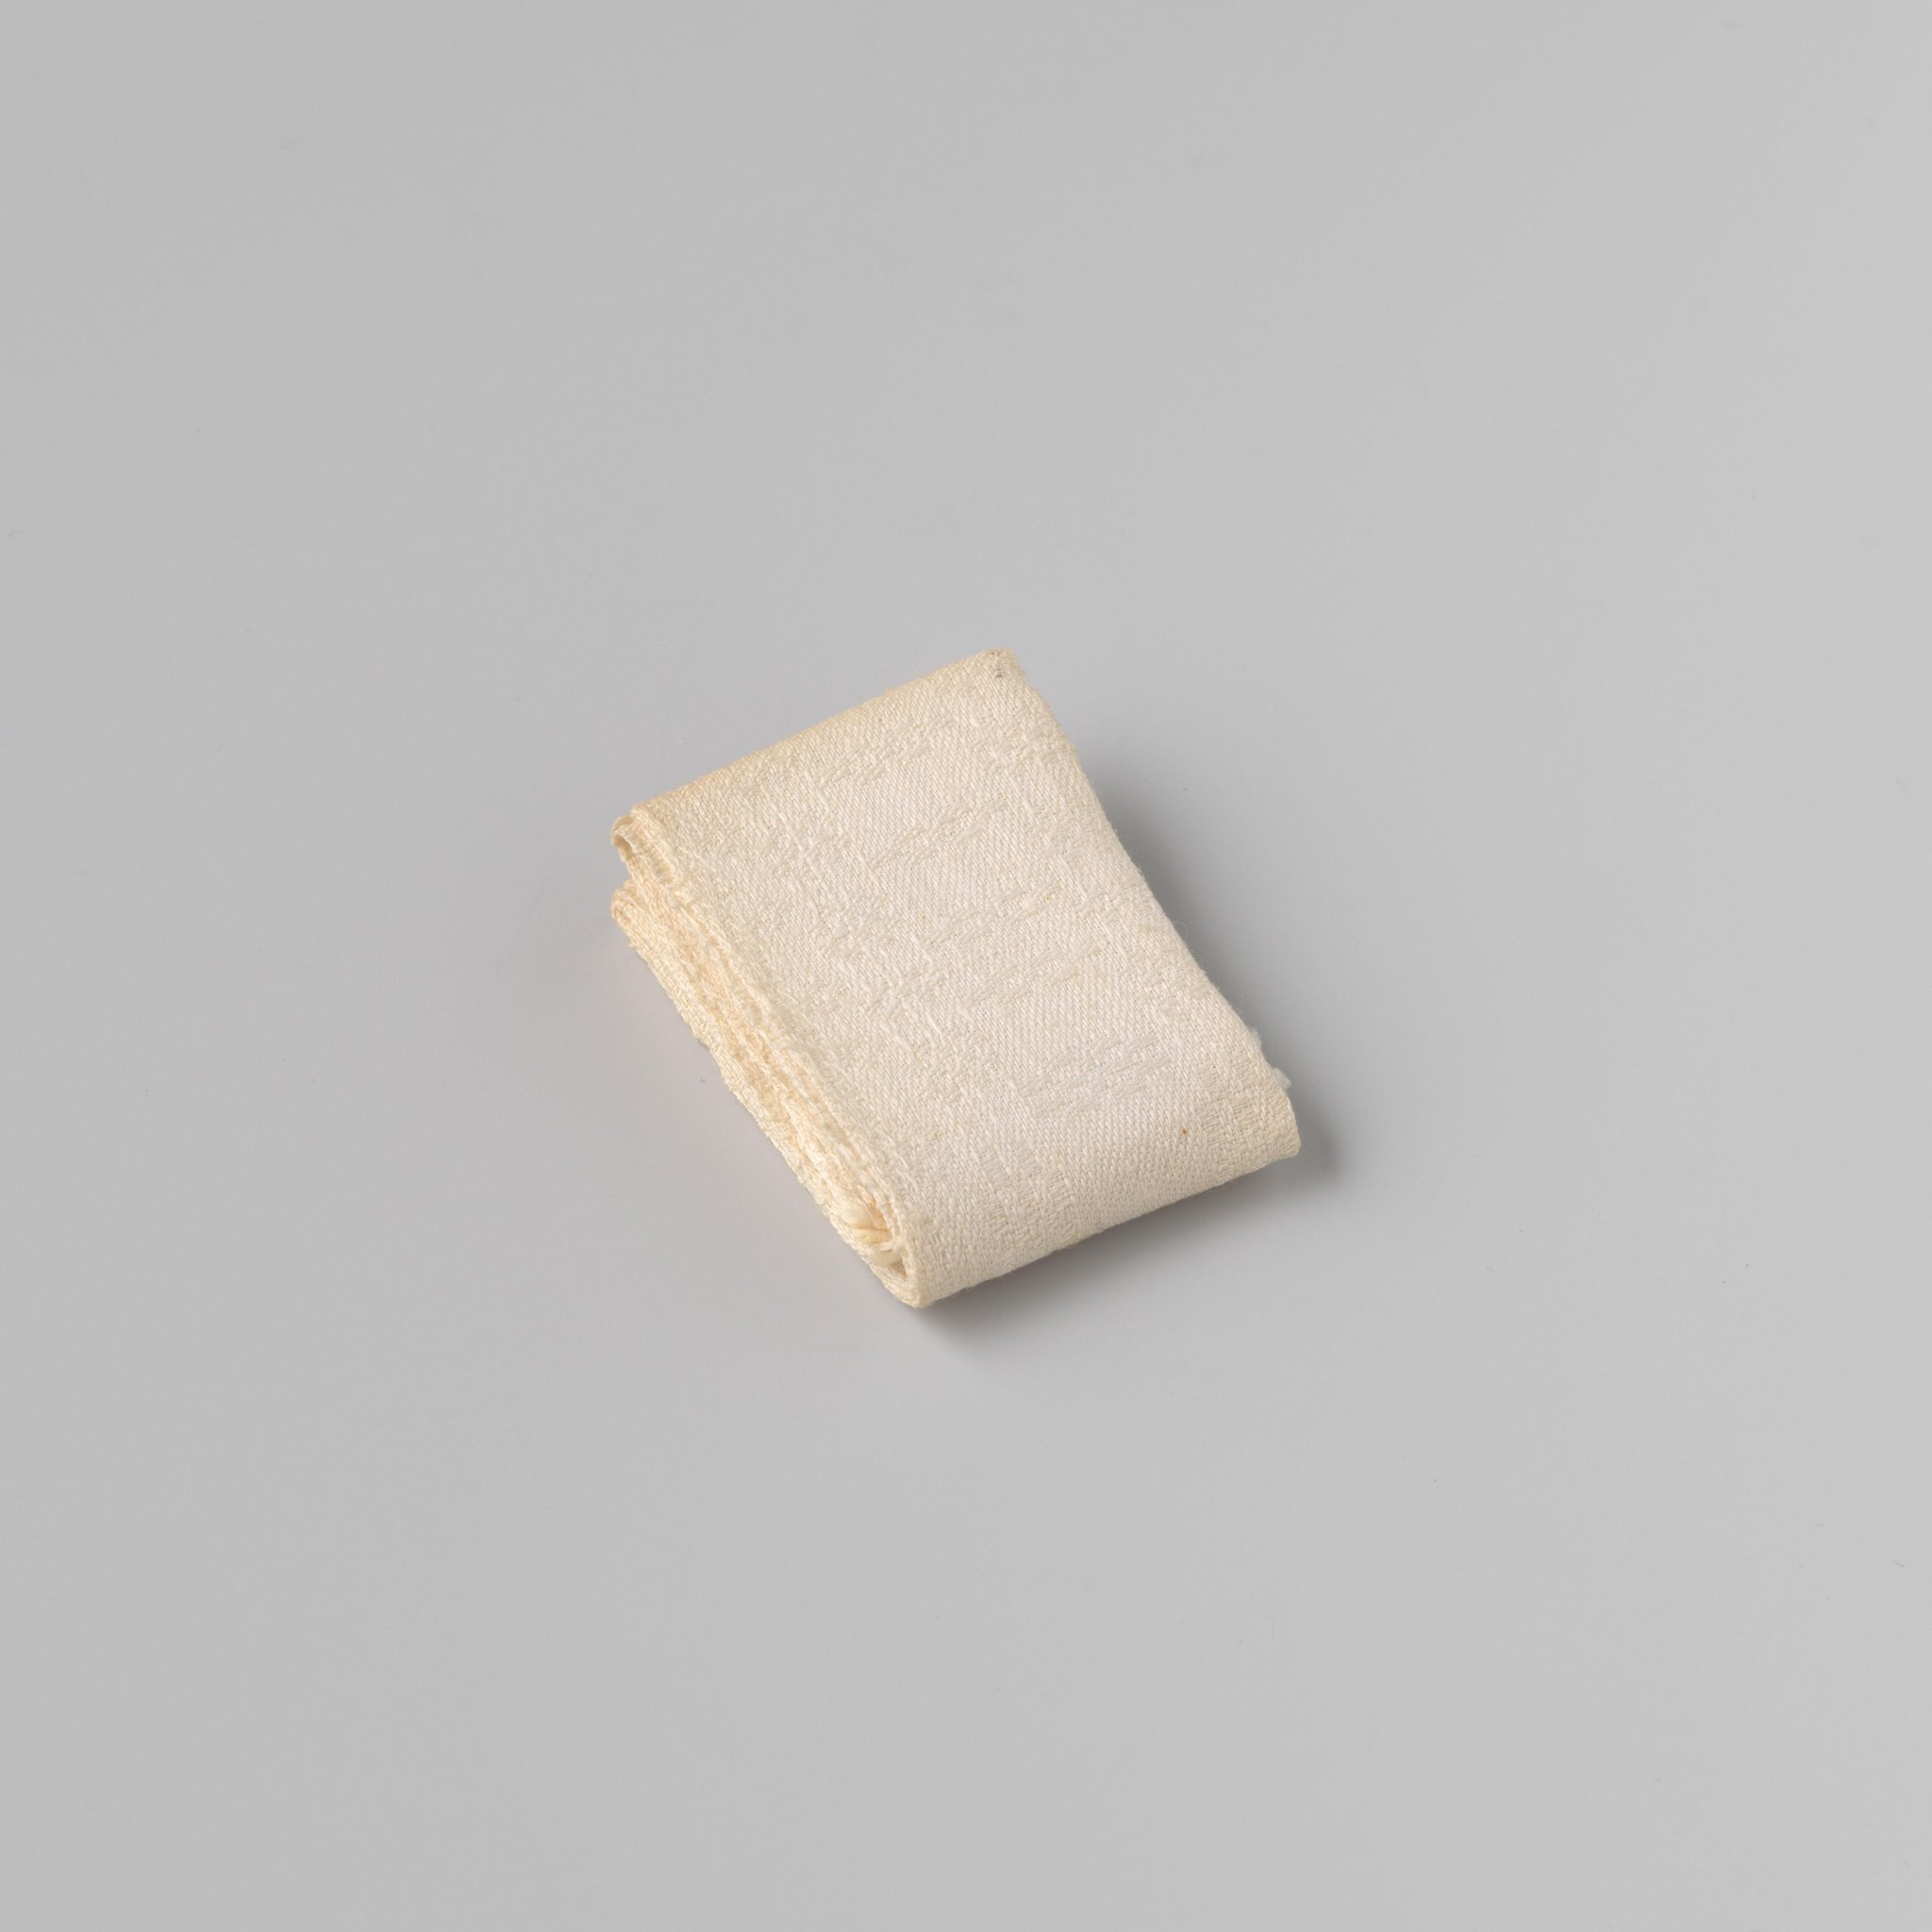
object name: napkin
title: Linnen servet van damastweefsel met pellenpatroon (motief III), geen zomen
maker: Anonymous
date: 1690-1710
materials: linen